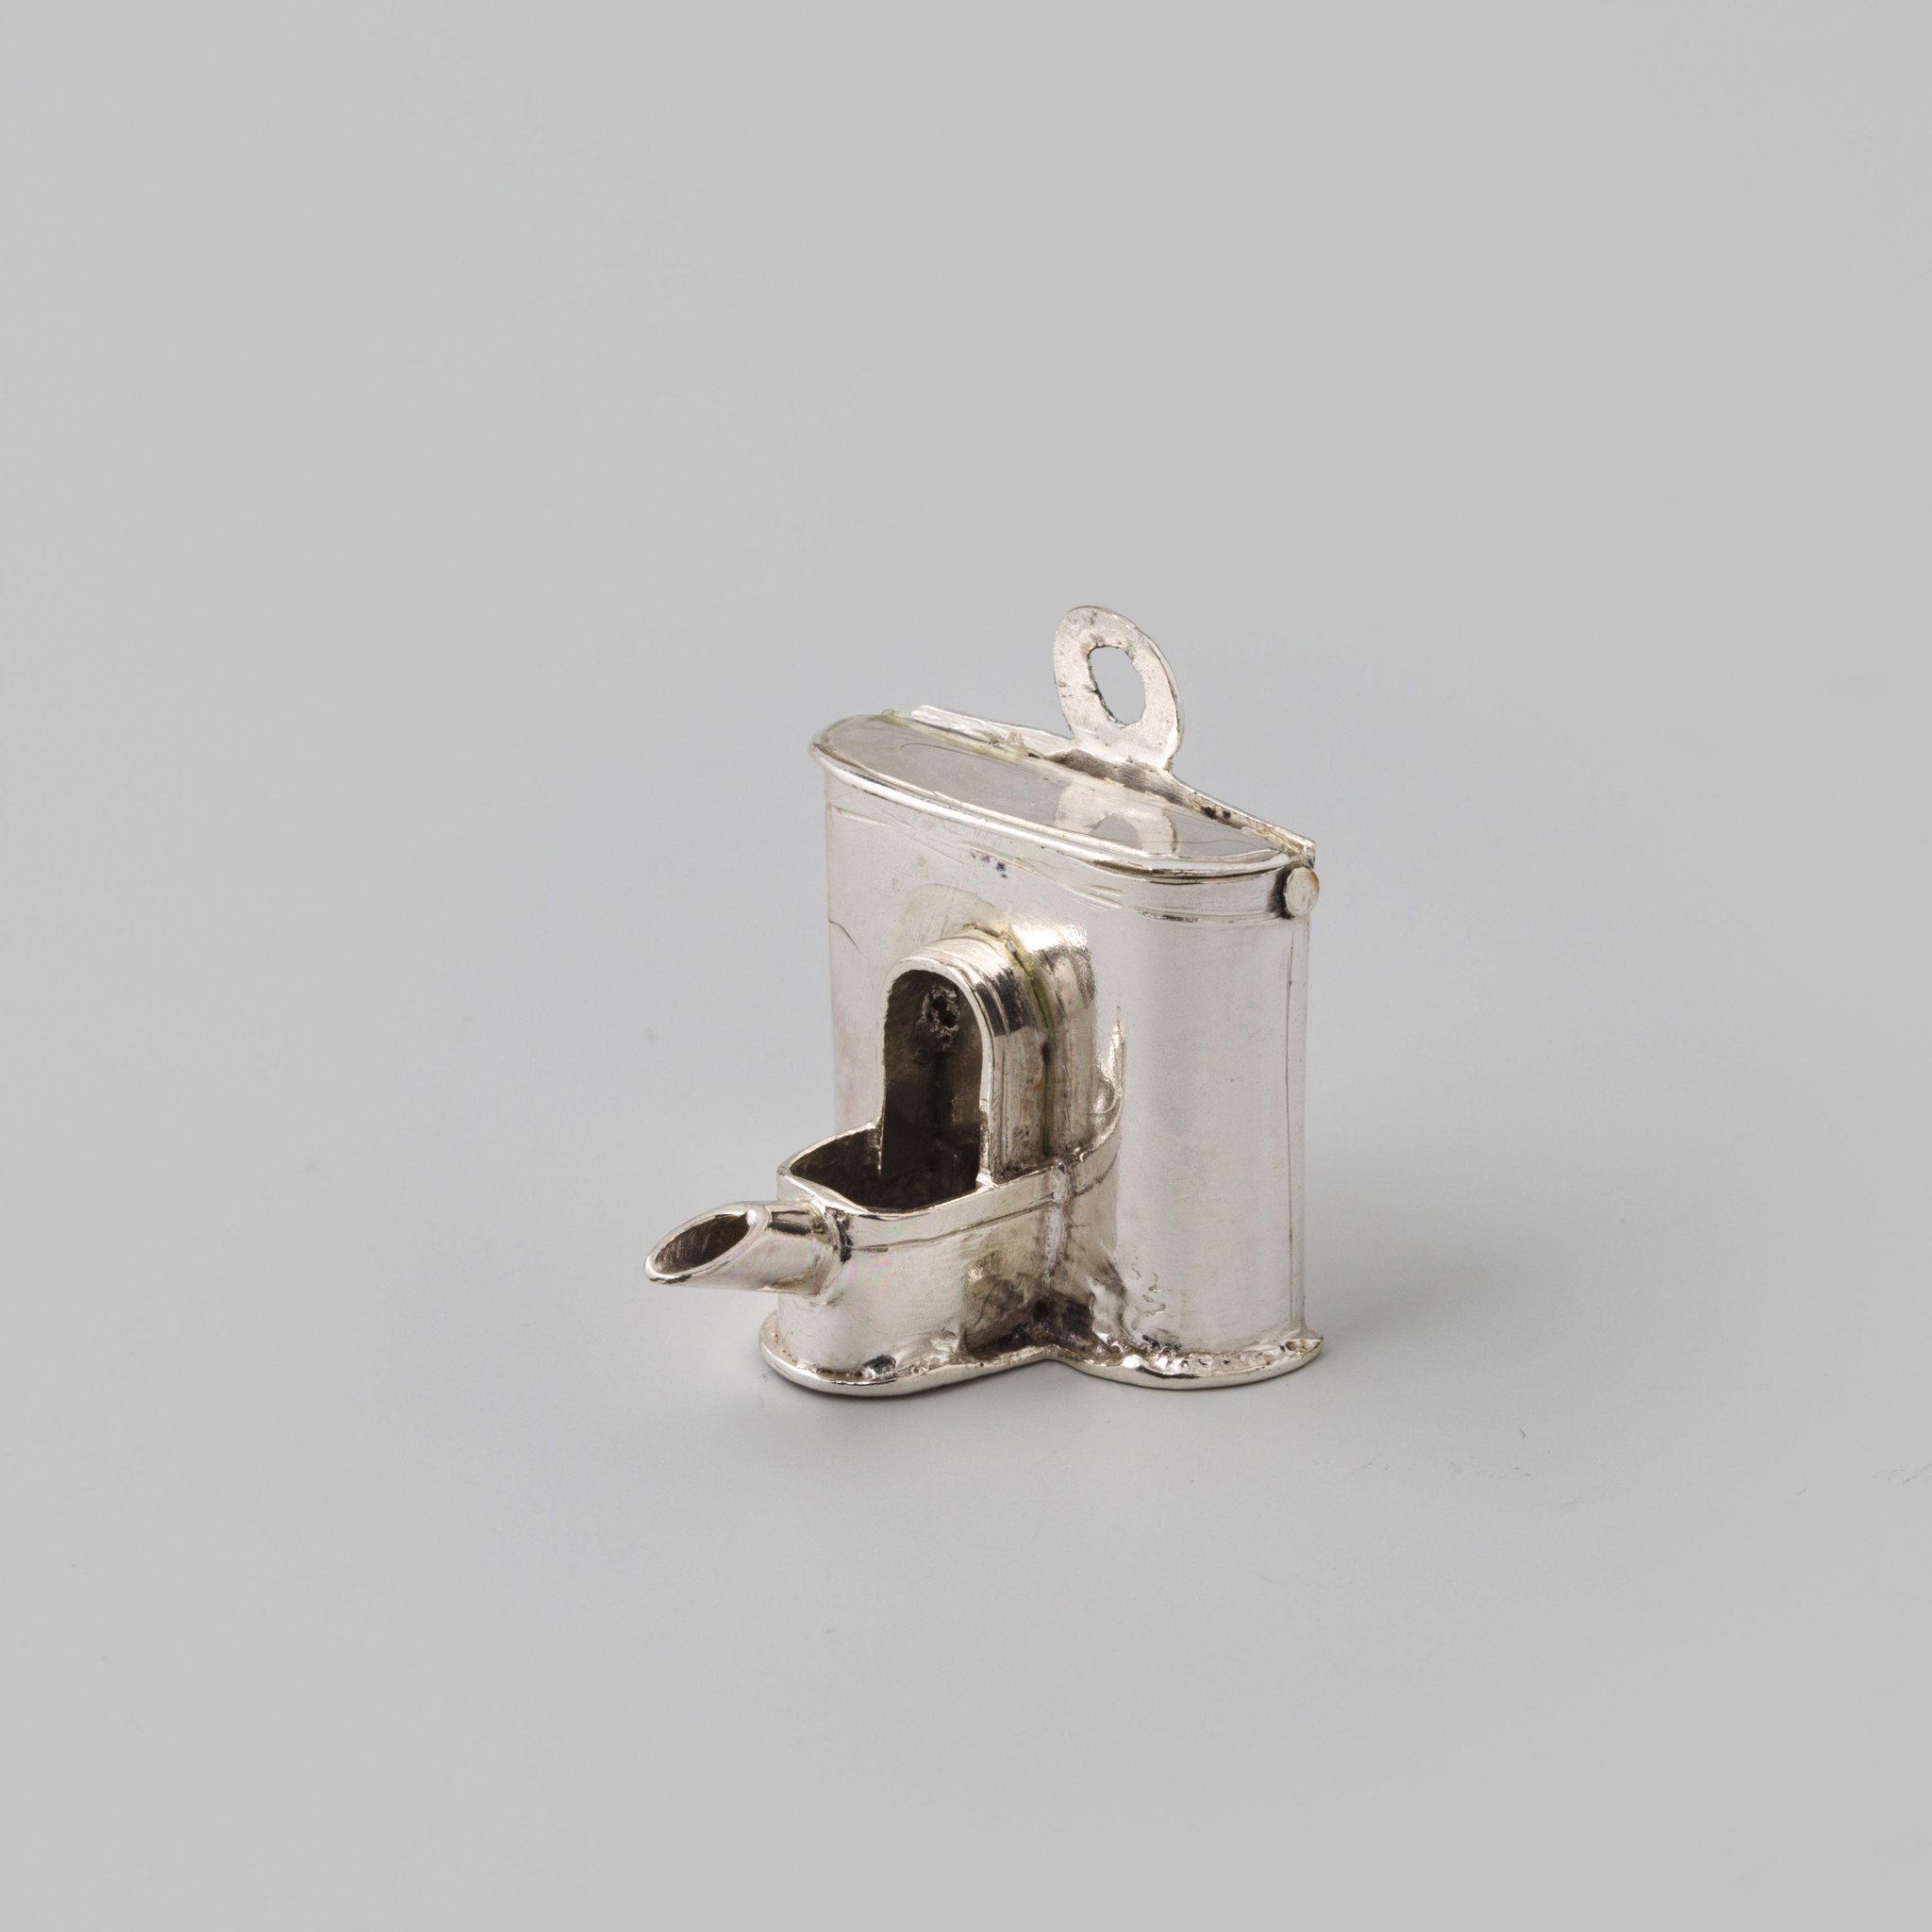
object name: miniature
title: Olielamp van zilver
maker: Anonymous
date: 1650-1699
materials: silver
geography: amsterdam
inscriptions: maker's mark: ‘onduidelijk meesterteken’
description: Olielamp van zilver met hoog, plat oliereservoir met klapdeksel. Aan de voorkant een open bakje en tuit. Aan de achterkant een draagoog.